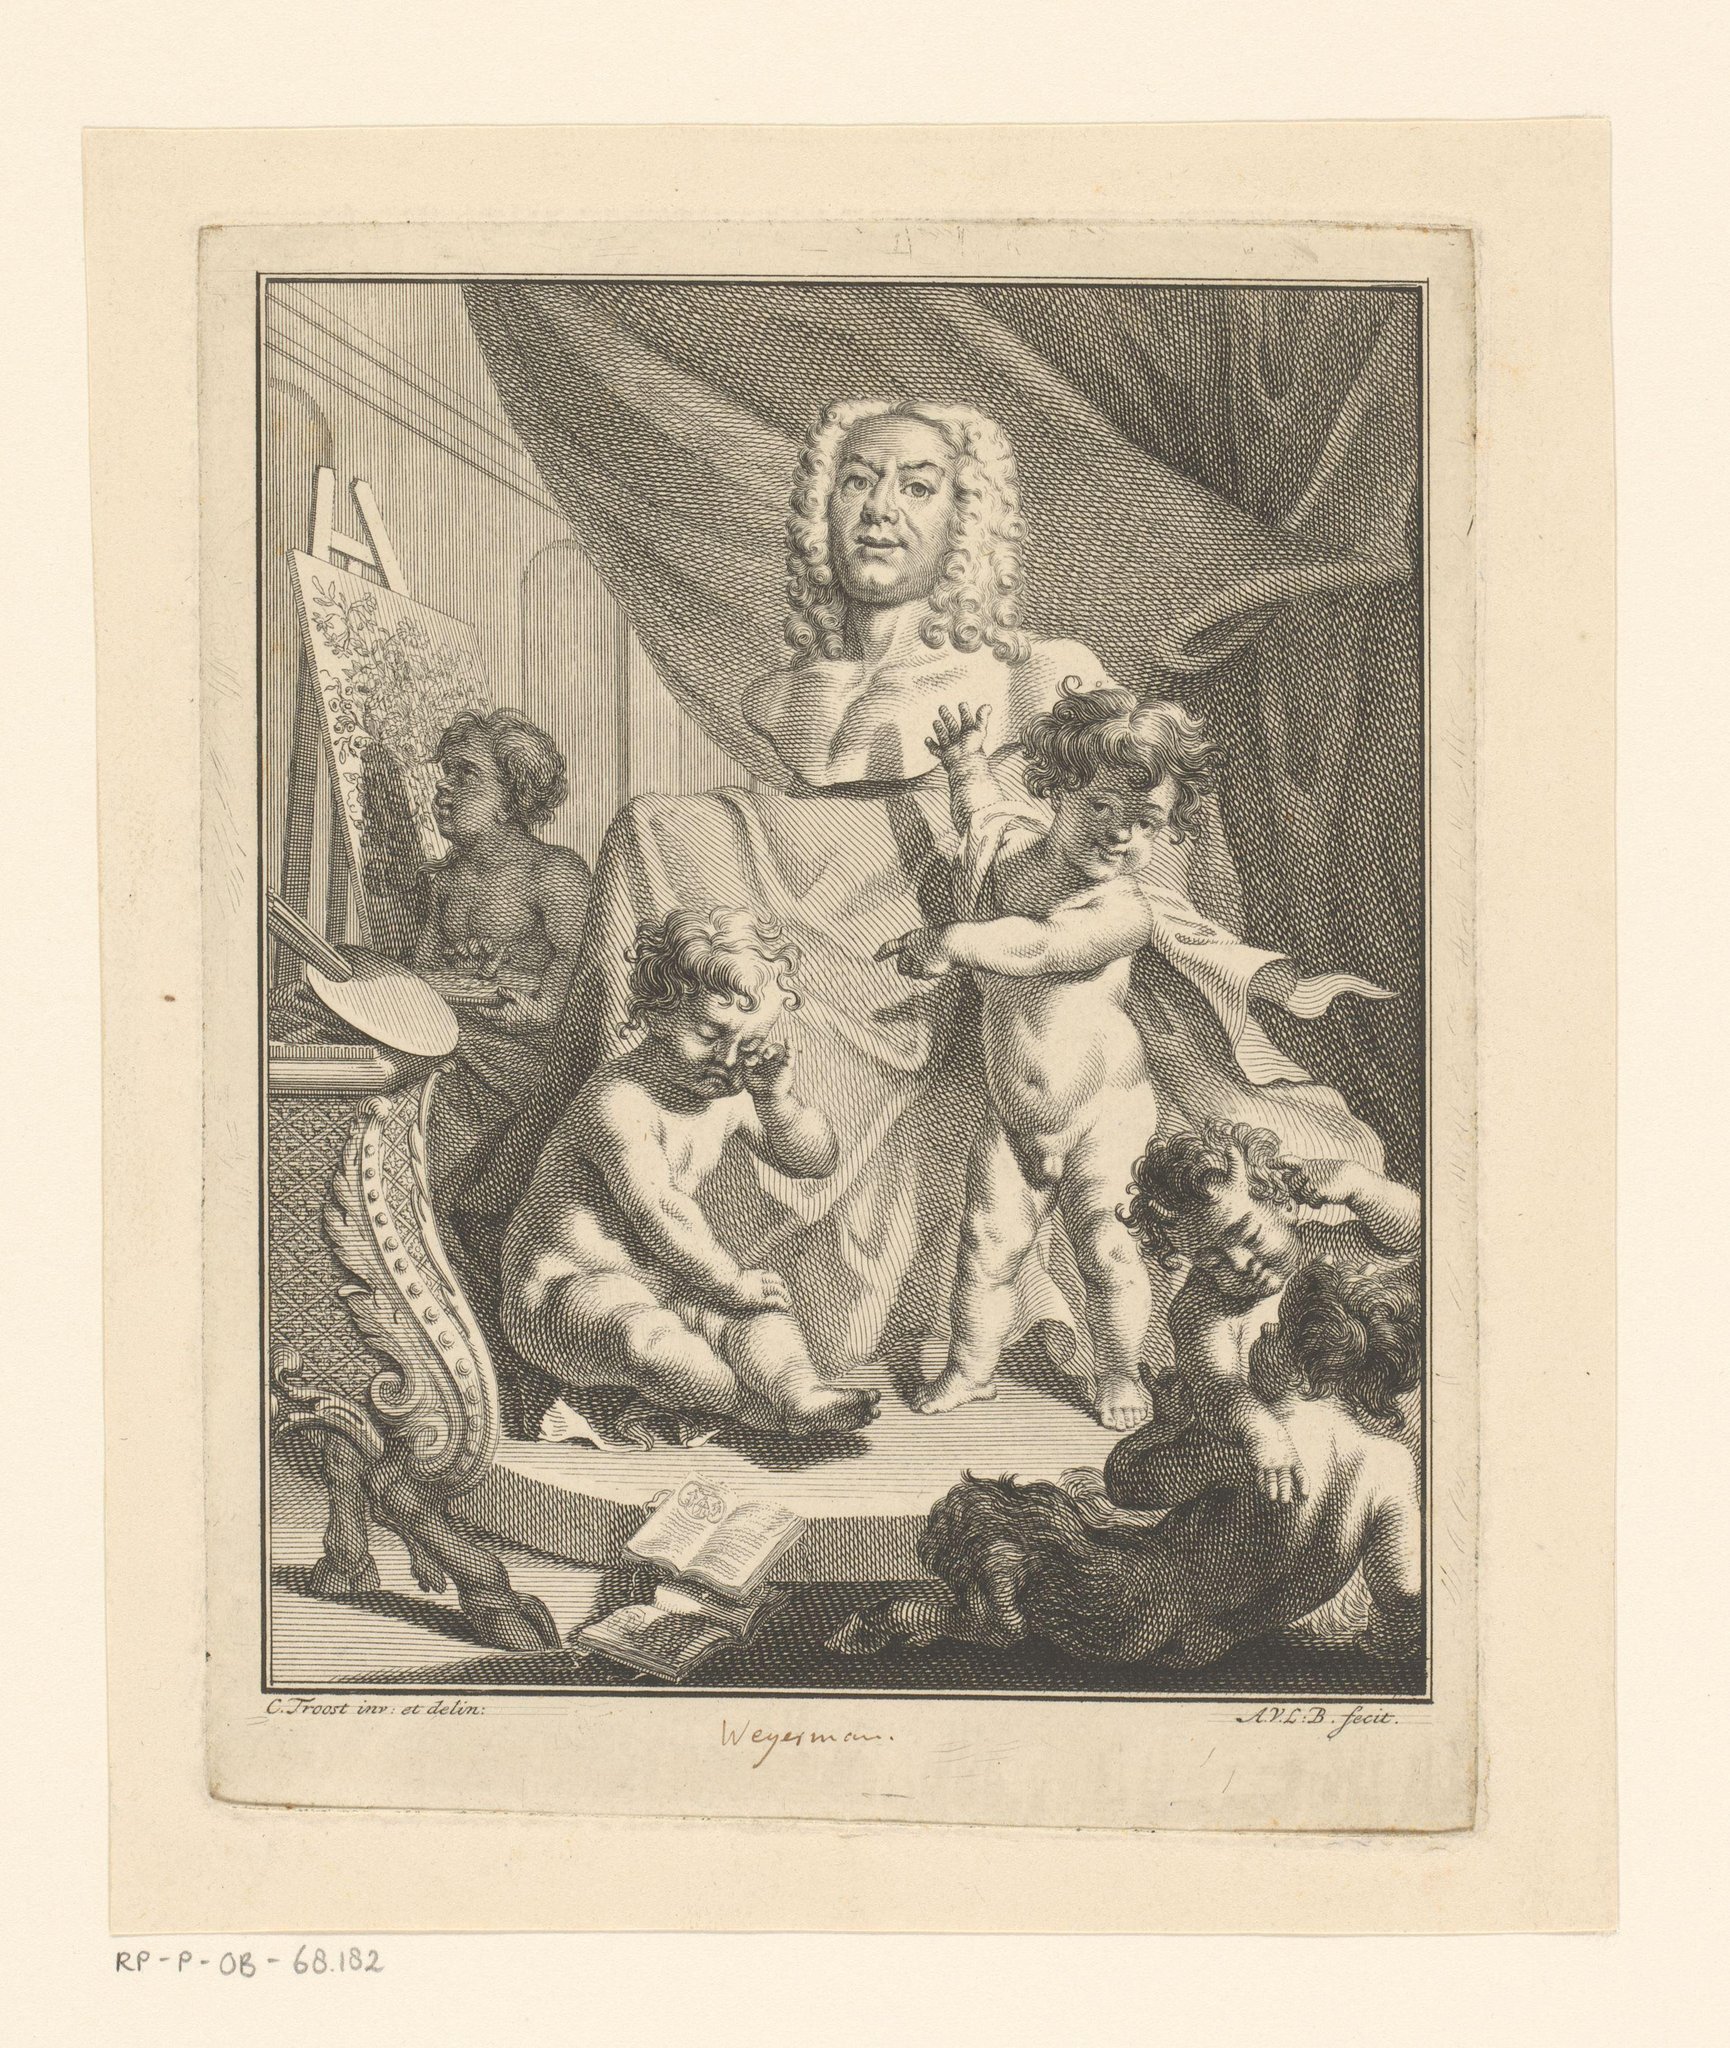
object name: print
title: Putti rond een buste van Jacob Campo Weyerman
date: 1747-1750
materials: paper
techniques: engraving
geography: low countries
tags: the hague, painter, print maker, jacob campo weyerman, historical persons, title-page, satyr(s) (in general), weeping, painting (including book-illumination, miniature-painting), cupids: 'amores', 'amoretti', 'putti'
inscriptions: collector's mark: Lugt 240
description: Op een verhoging staat een buste van de kunstenaar en auteur Jacob Campo Weyerman. Voor de buste staat een putto, die met z'n ene hand naar de buste wijst en met z'n andere hand naar de treurende putto naast hem. Linksachter een putto met schildersbenodigdheden bij een ezel. Linksvoor liggen enkele opengeslagen boeken. Rechtsvoor omhelzen twee jonge saters elkaar.